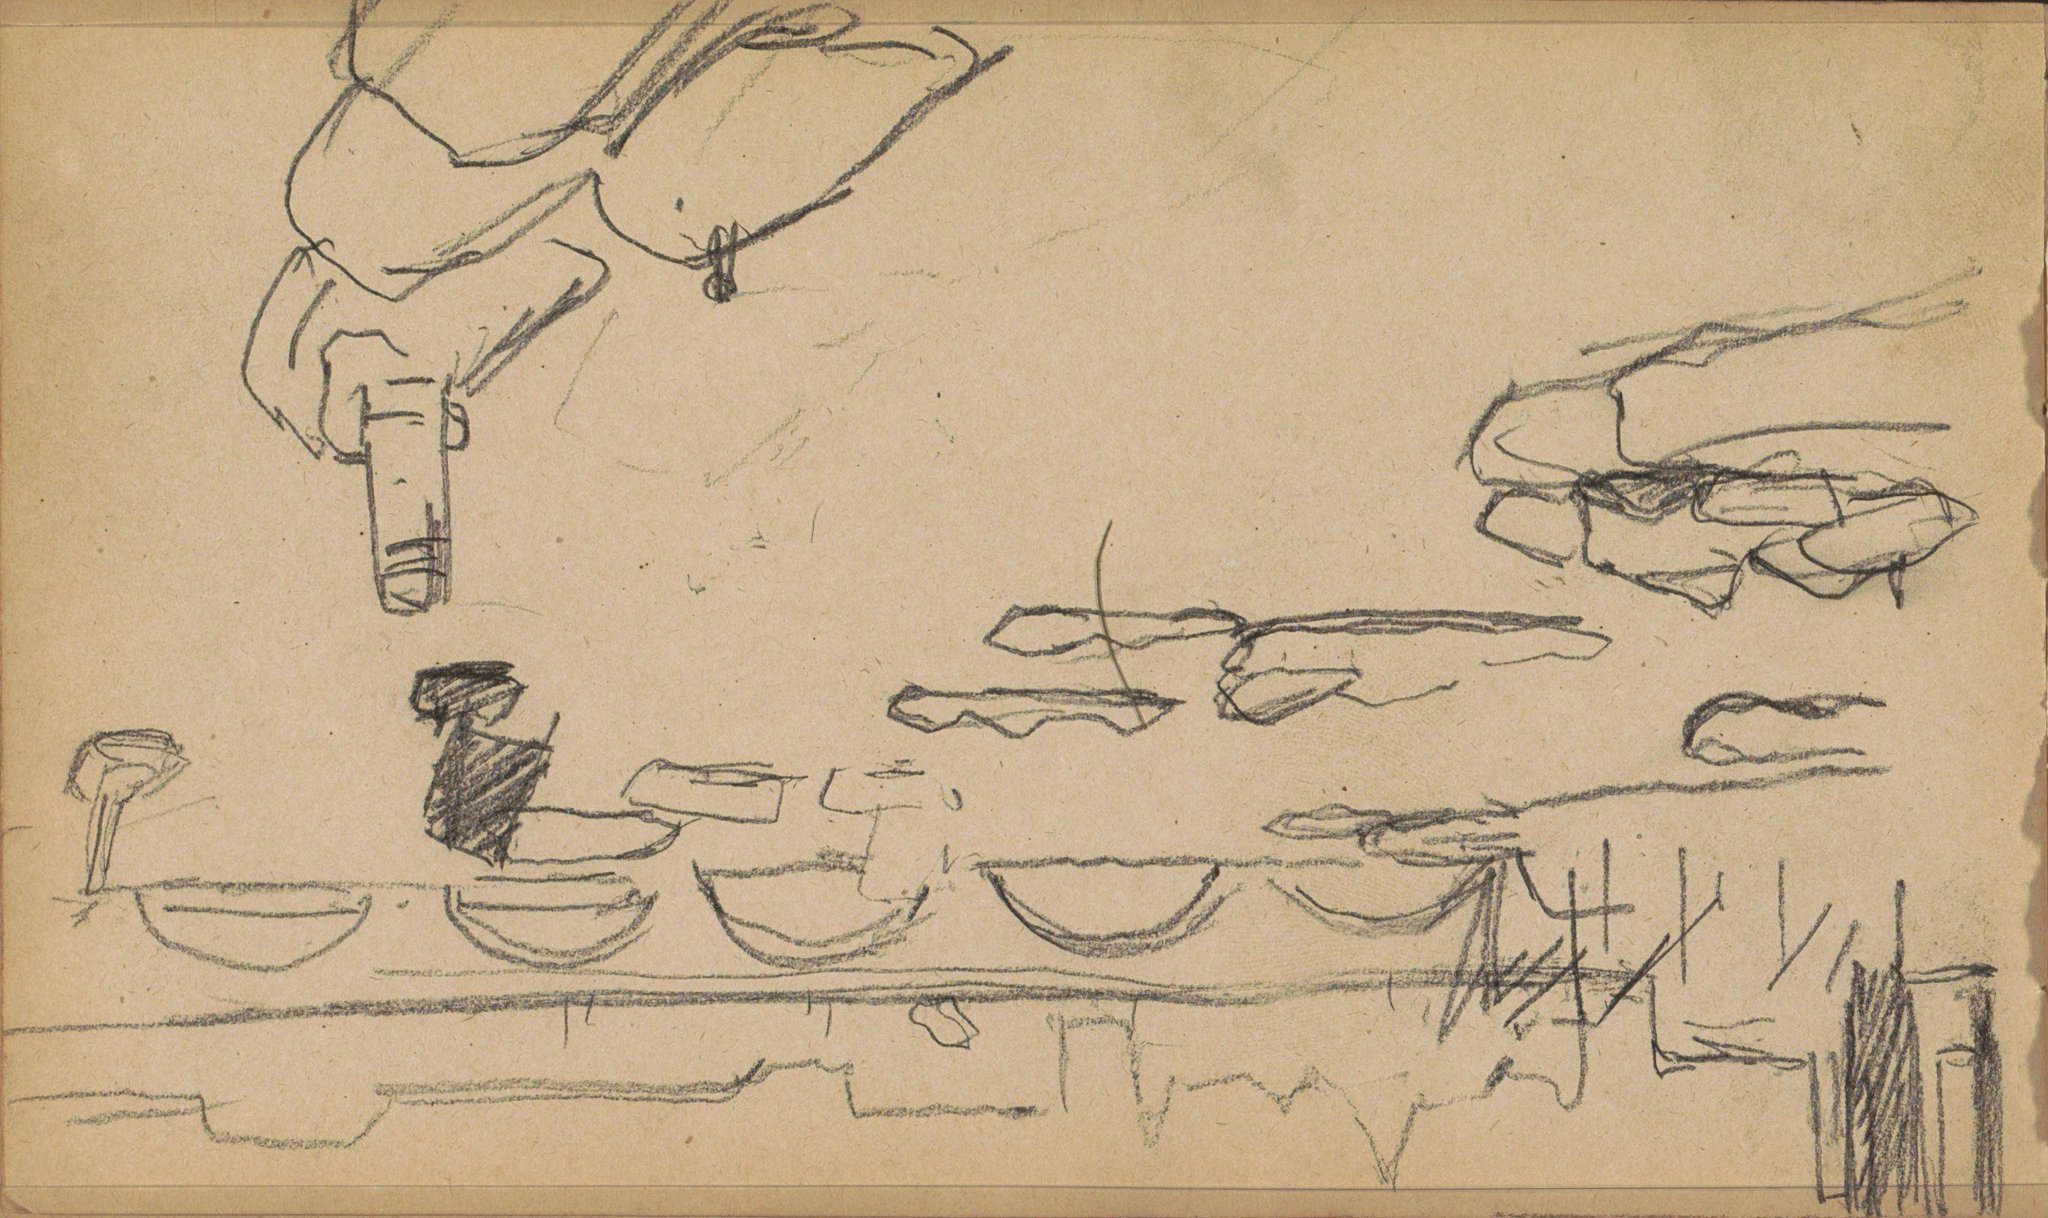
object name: sketchbook leaf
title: Boten op de Theems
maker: willem witsen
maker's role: draughtsman, painter, print maker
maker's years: 1860-1923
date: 1888-1891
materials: chalk, paper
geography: london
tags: ships (in general), bridge in city across river, canal, etc., thames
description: Gezien vanaf Blackfriars Bridge naar Waterloo Bridge. Achter de brug hotels, Charing Cross Station en Whitehall Court. Links hageltorens. Pagina 24 uit een schetsboek met 25 bladen.